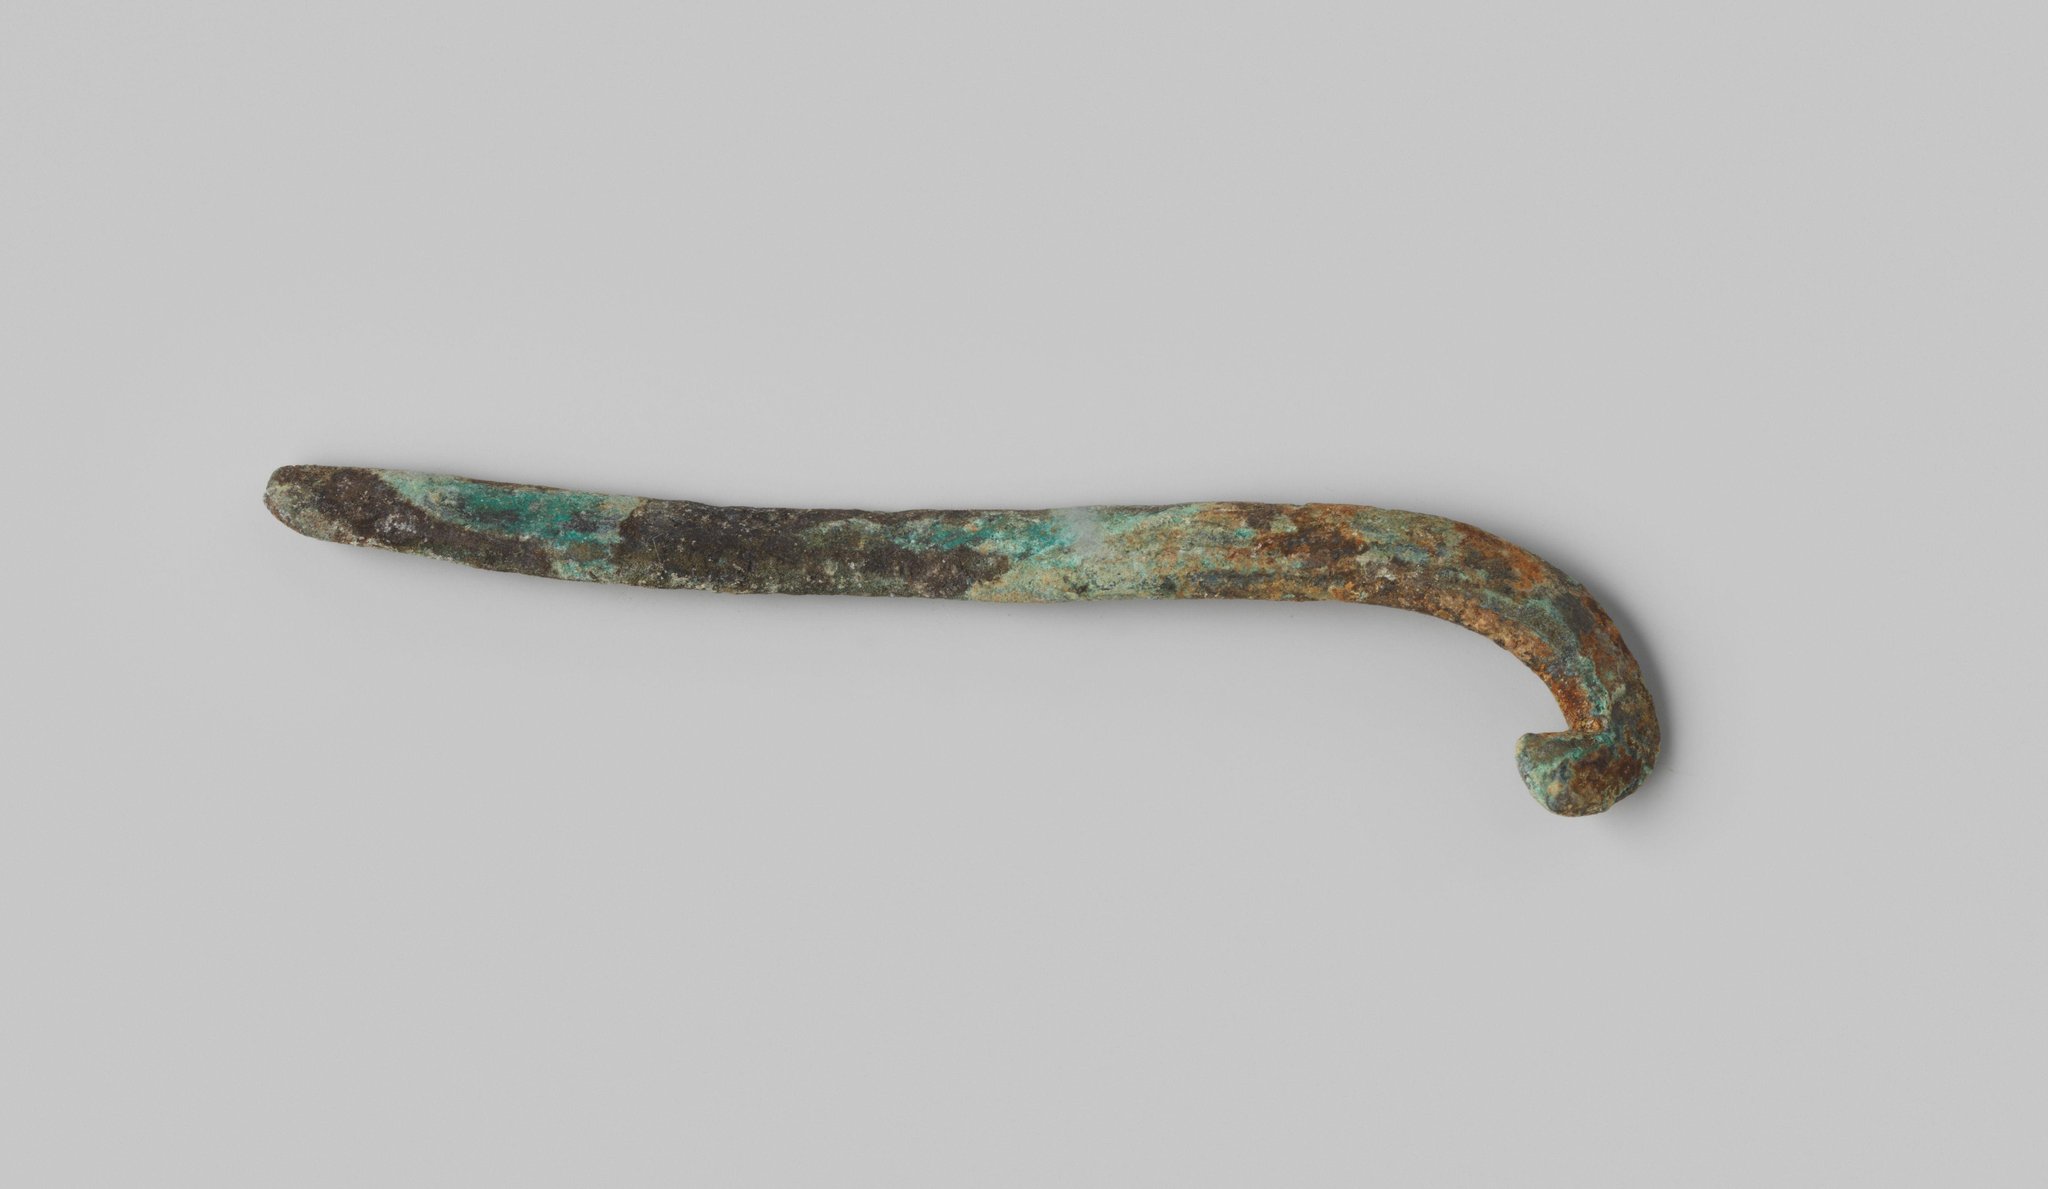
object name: belt buckle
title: Fragment riemgesp uit het wrak van de Oost-Indiëvaarder Hollandia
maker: Anonymous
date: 1700-1743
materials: copper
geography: netherlands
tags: verenigde oostindische compagnie, hollandia (schip), annet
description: Rectangular, fragm of ring, id. NG 1980-27H2852, belt buckle.